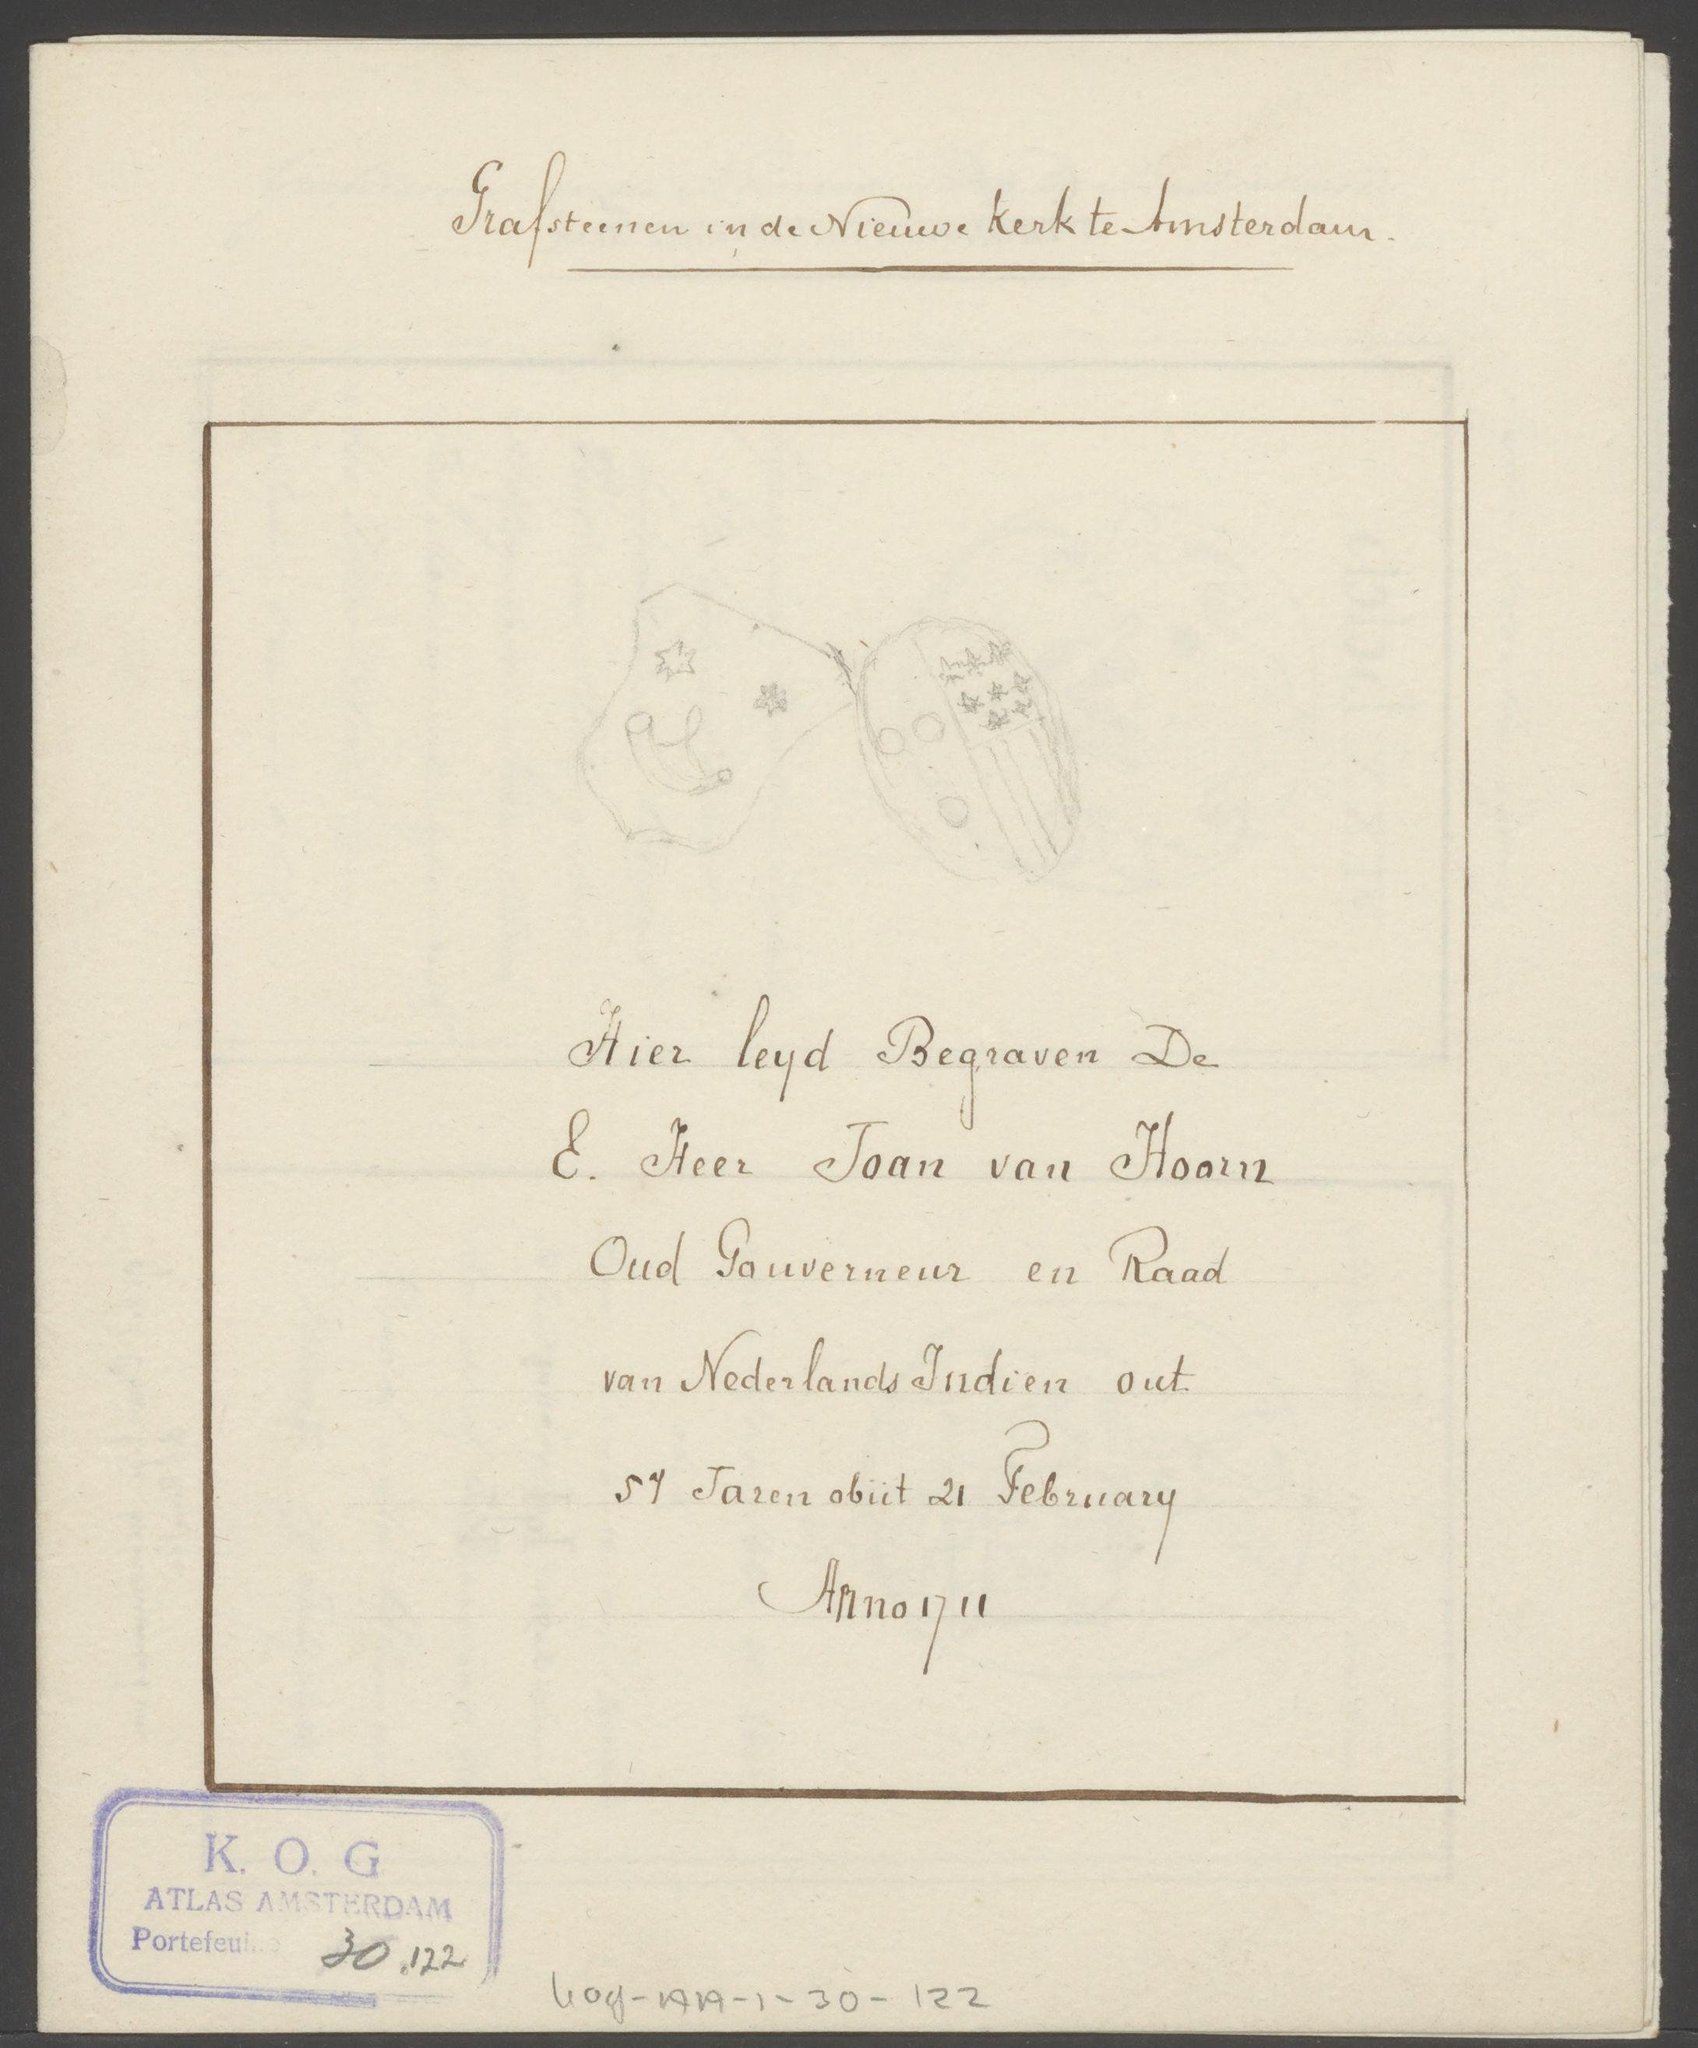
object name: drawing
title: Wapens en grafschriften in de Nieuwe Kerk te Amsterdam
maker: Anonymous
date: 1854-1900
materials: ink, paper, pencil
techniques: brush, pen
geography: amsterdam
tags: gravestone, tombstone, armorial bearing, heraldry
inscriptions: collector's mark: Lugt 1641b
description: Object bestaat uit veertien pagina's waarvan sommige onbeschreven. Onderwerpsrubriek binnen de Atlas Amsterdam: Kerkwezen: Hervormde Gemeente: Nieuwe Kerk van binnen.